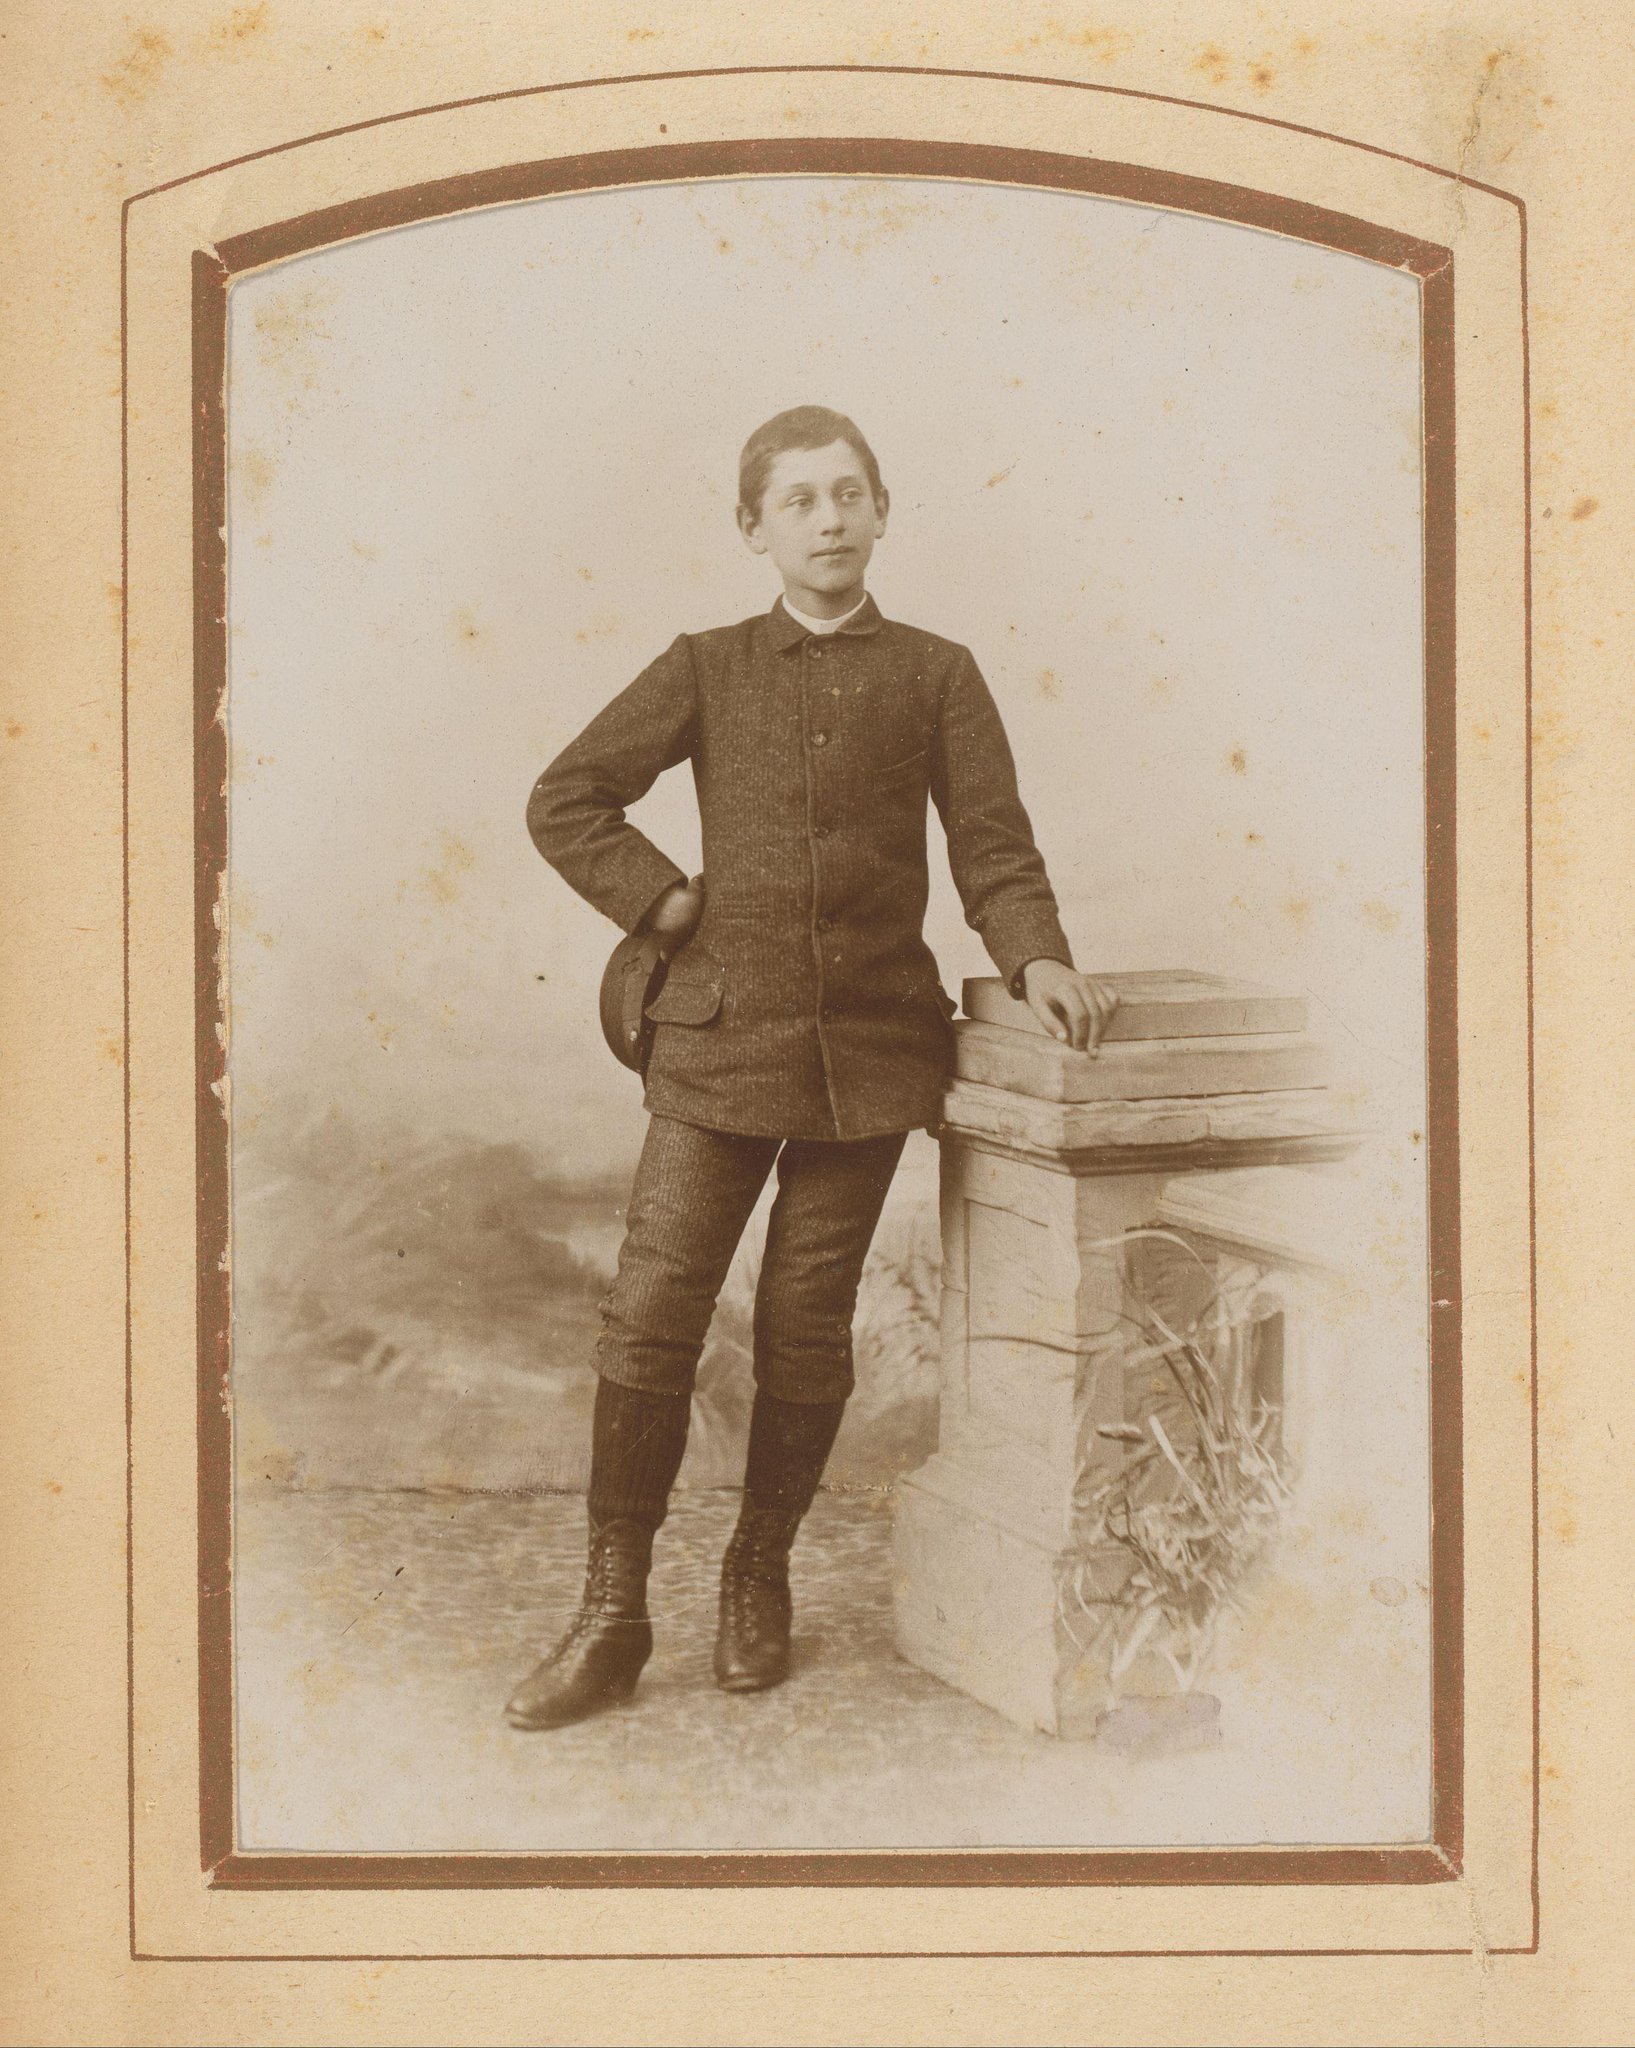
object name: photograph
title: Portret van een jongen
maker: Anonymous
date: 1880-1910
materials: cardboard, photographic support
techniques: collodion silver print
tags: boy (child between toddler and youth), historical persons